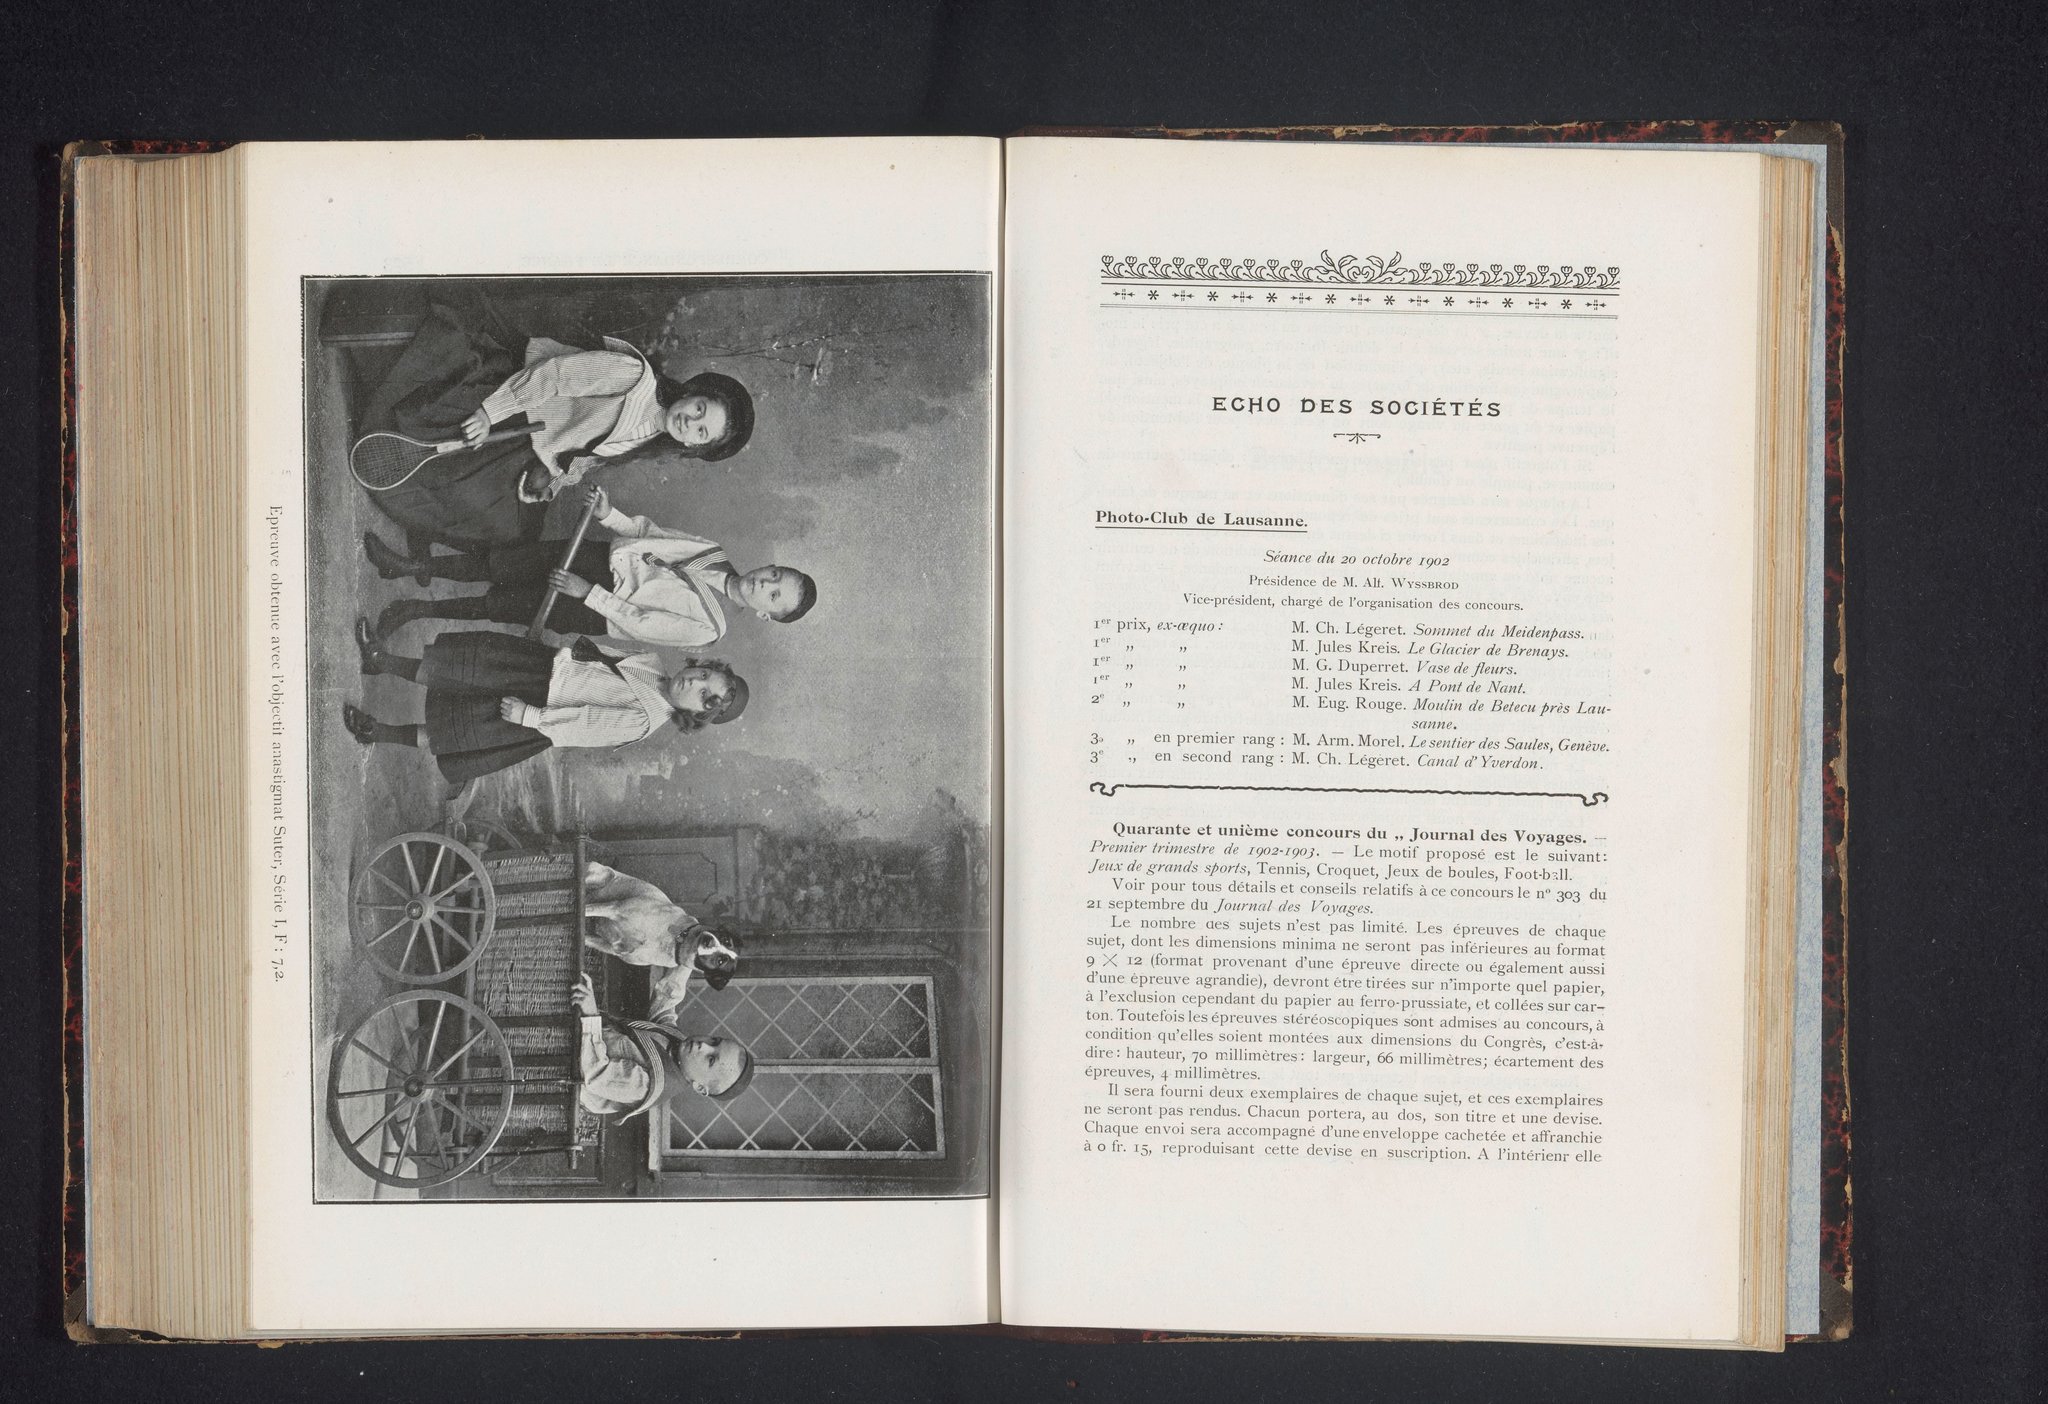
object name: photomechanical print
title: Groepsportret van kinderen met attributen, een kar en een hond.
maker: Anonymous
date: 1897-1902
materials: paper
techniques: autotype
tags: hand-cart, dog, anonymous historical persons portrayed in a group, in a group-portrait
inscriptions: inscription: ‘Epreuve obenue avec l'objectif anastigmat Suter, Série I, F:7,2’